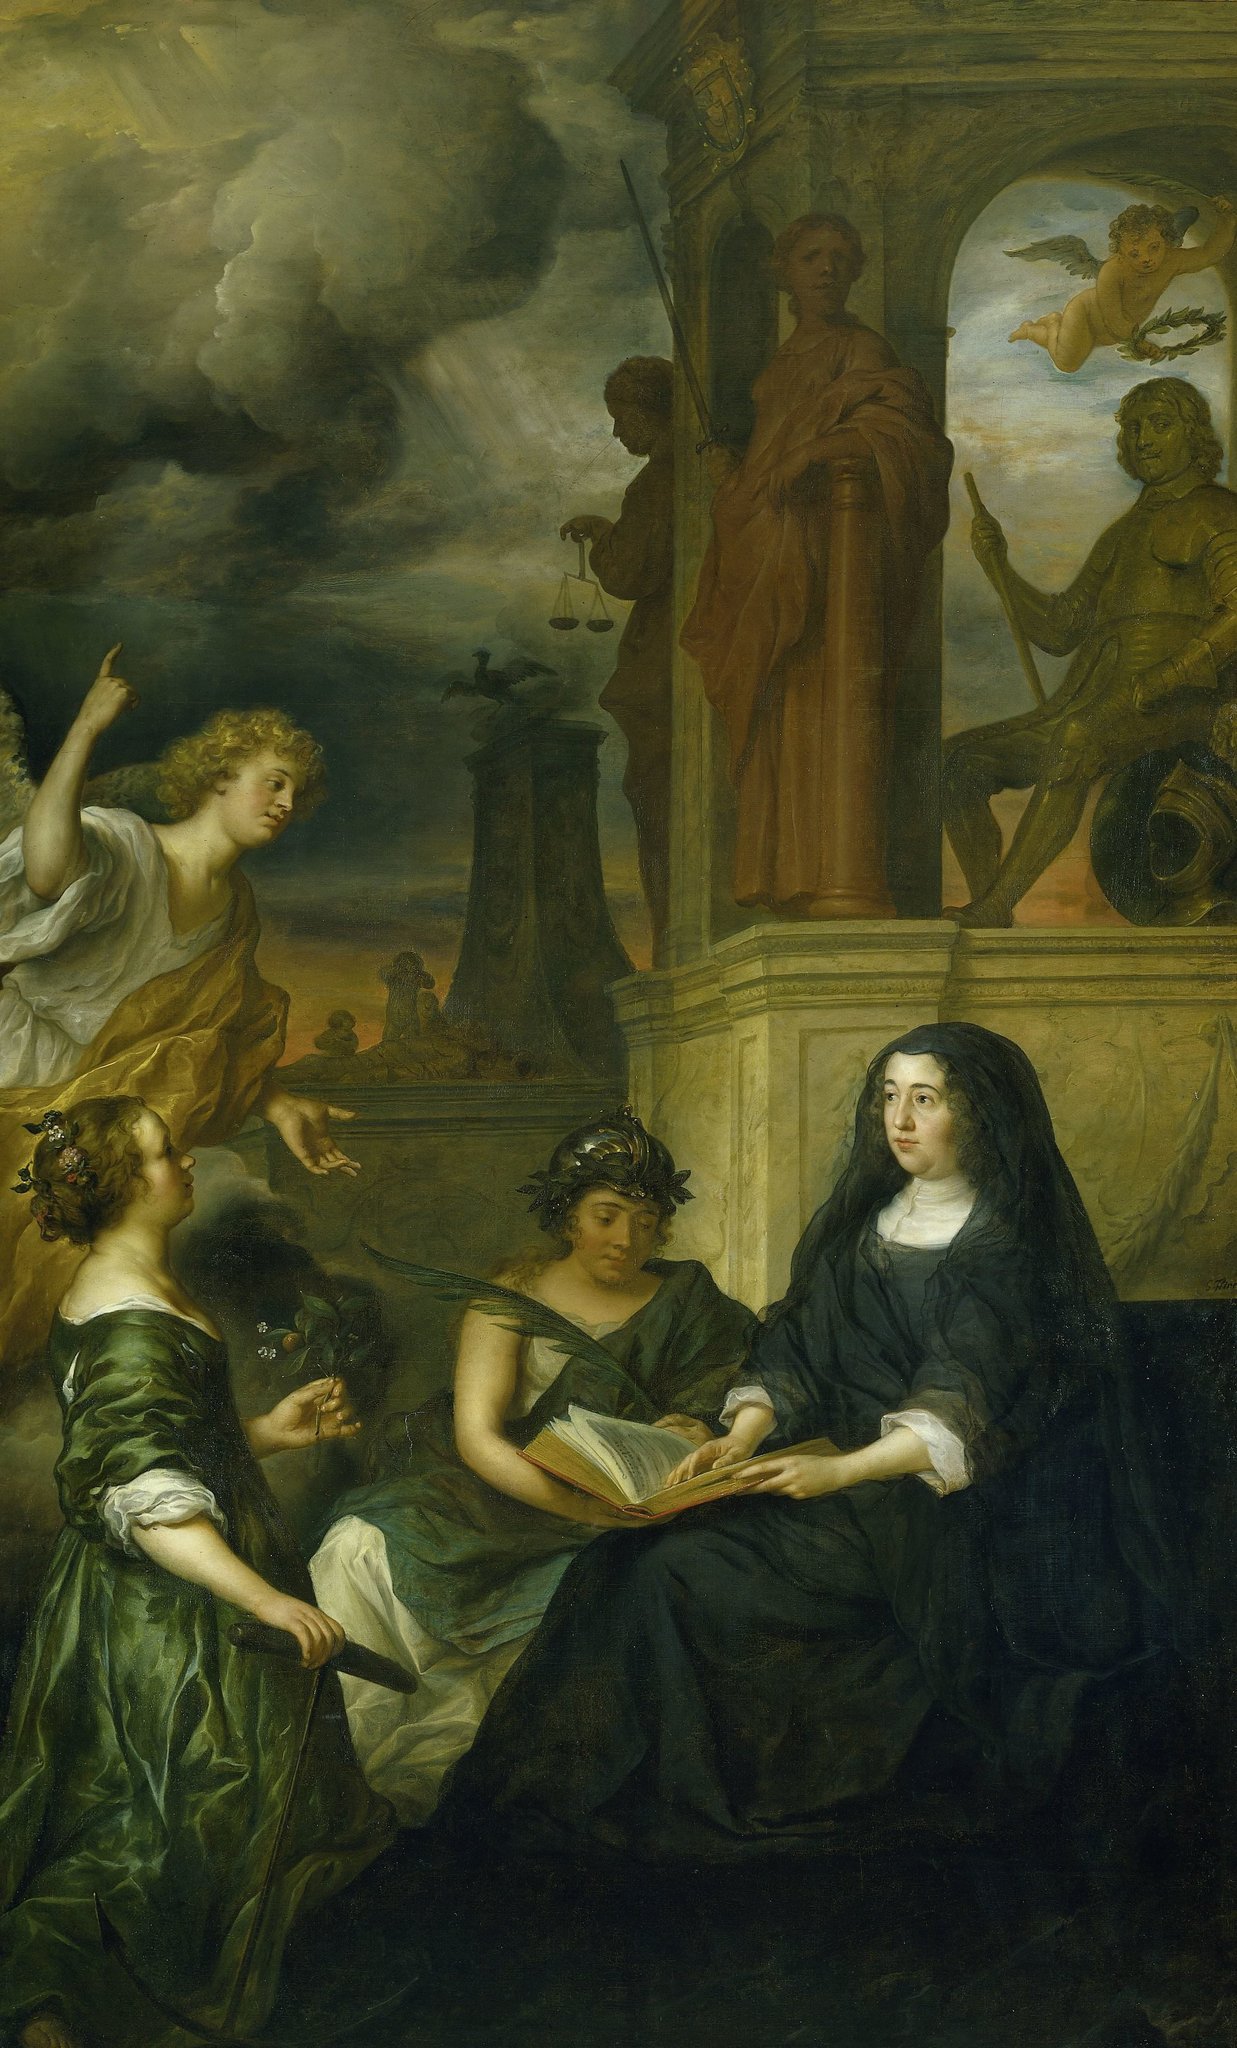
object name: painting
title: Allegory on the Memory of Frederik Hendrik (1584-1647), Prince of Orange, with the Portrait of his Widow Amalia van Solms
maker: govert flinck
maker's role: draughtsman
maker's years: 1615-1660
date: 1654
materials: canvas, oil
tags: the hague, amalia of solms-braunfels, historical persons - bb - woman, dress, gown: morning dress, widow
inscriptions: signature and date, centre right, on the tomb: ‘G. Flinck ft 1654’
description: Portret van de weduwe Amalia van Solms, allegorie op de nagedachtenis van Frederik Hendrik, prins van Oranje. Op de voorgrond zit de prinses in rouwkleding met een geopend boek op schoot. Naast haar een allegorische vrouwenfiguur met een helm op het hoofd en een palmtak in de hand. Voor haar knielt de personificatie van de Hoop, met een anker in de rechterhand en een bloeiende Oranjetak in de linker. Hierboven een engel die naar boven wijst. Op de achtergrond het grafmonument met een beeld van de zittende Frederik Hendrik in wapenrusting. Boven zijn hoofd een putto met een lauwerkrans. Aan de voorzijde van het monument standbeelden van Rechtvaardigheid en Kracht. Op de achtergrond een herrijzende feniks.